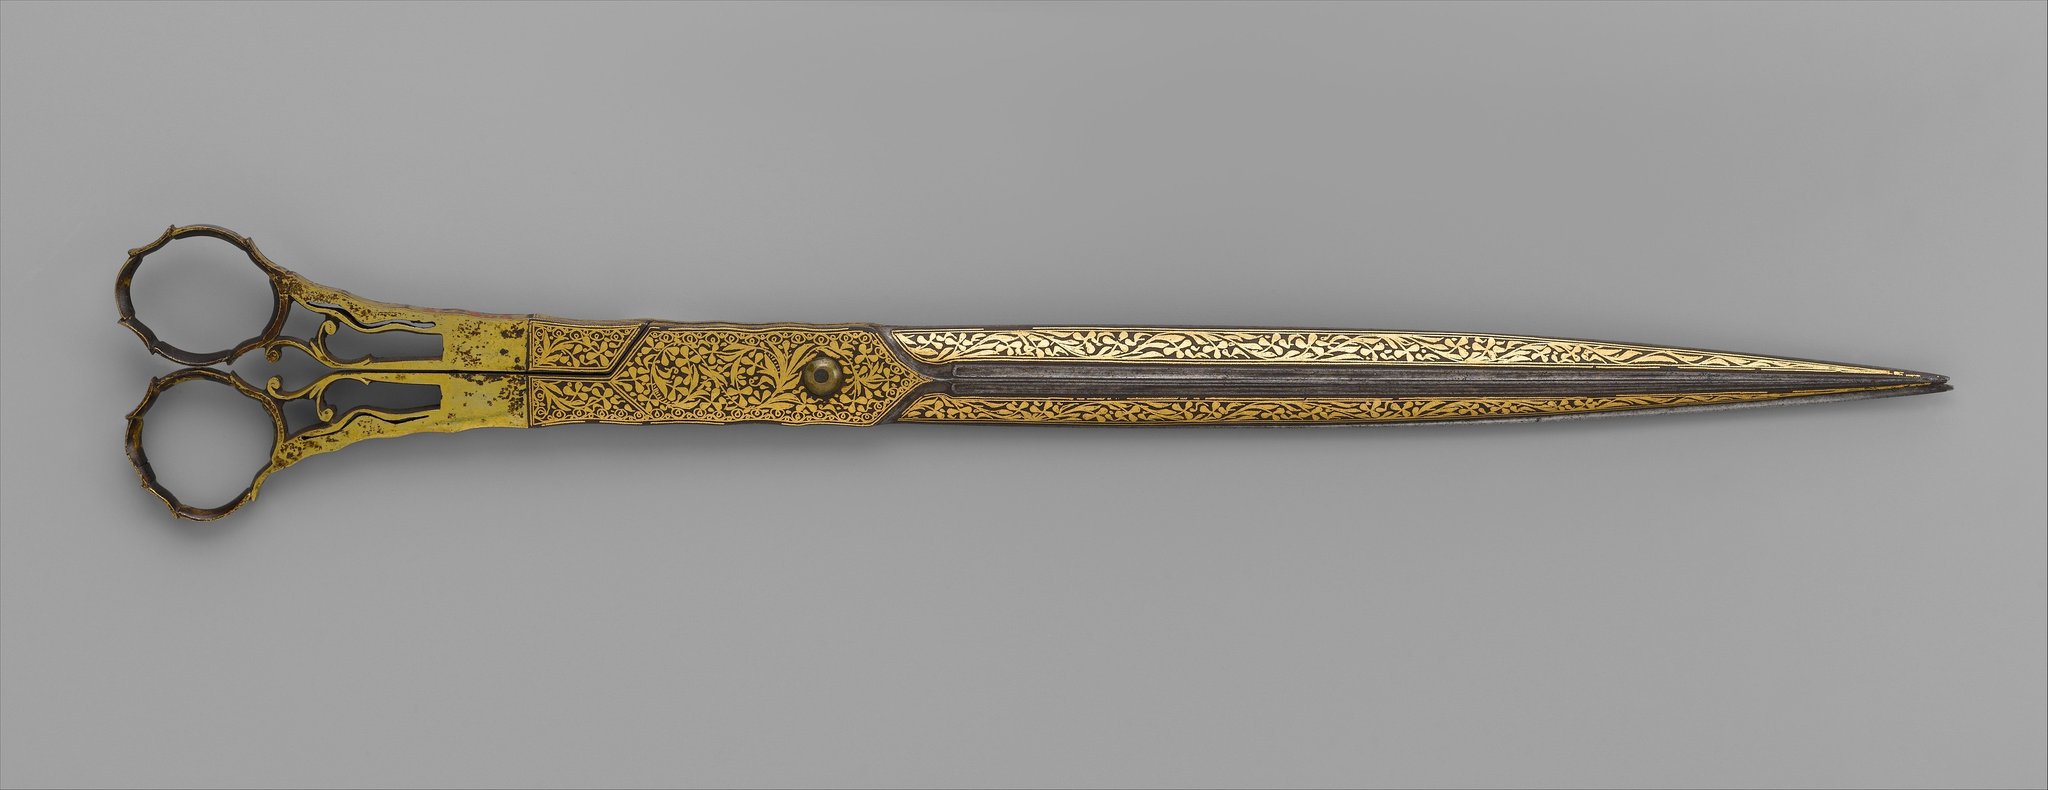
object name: scissors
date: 1701-1900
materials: gold, steel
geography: turkey